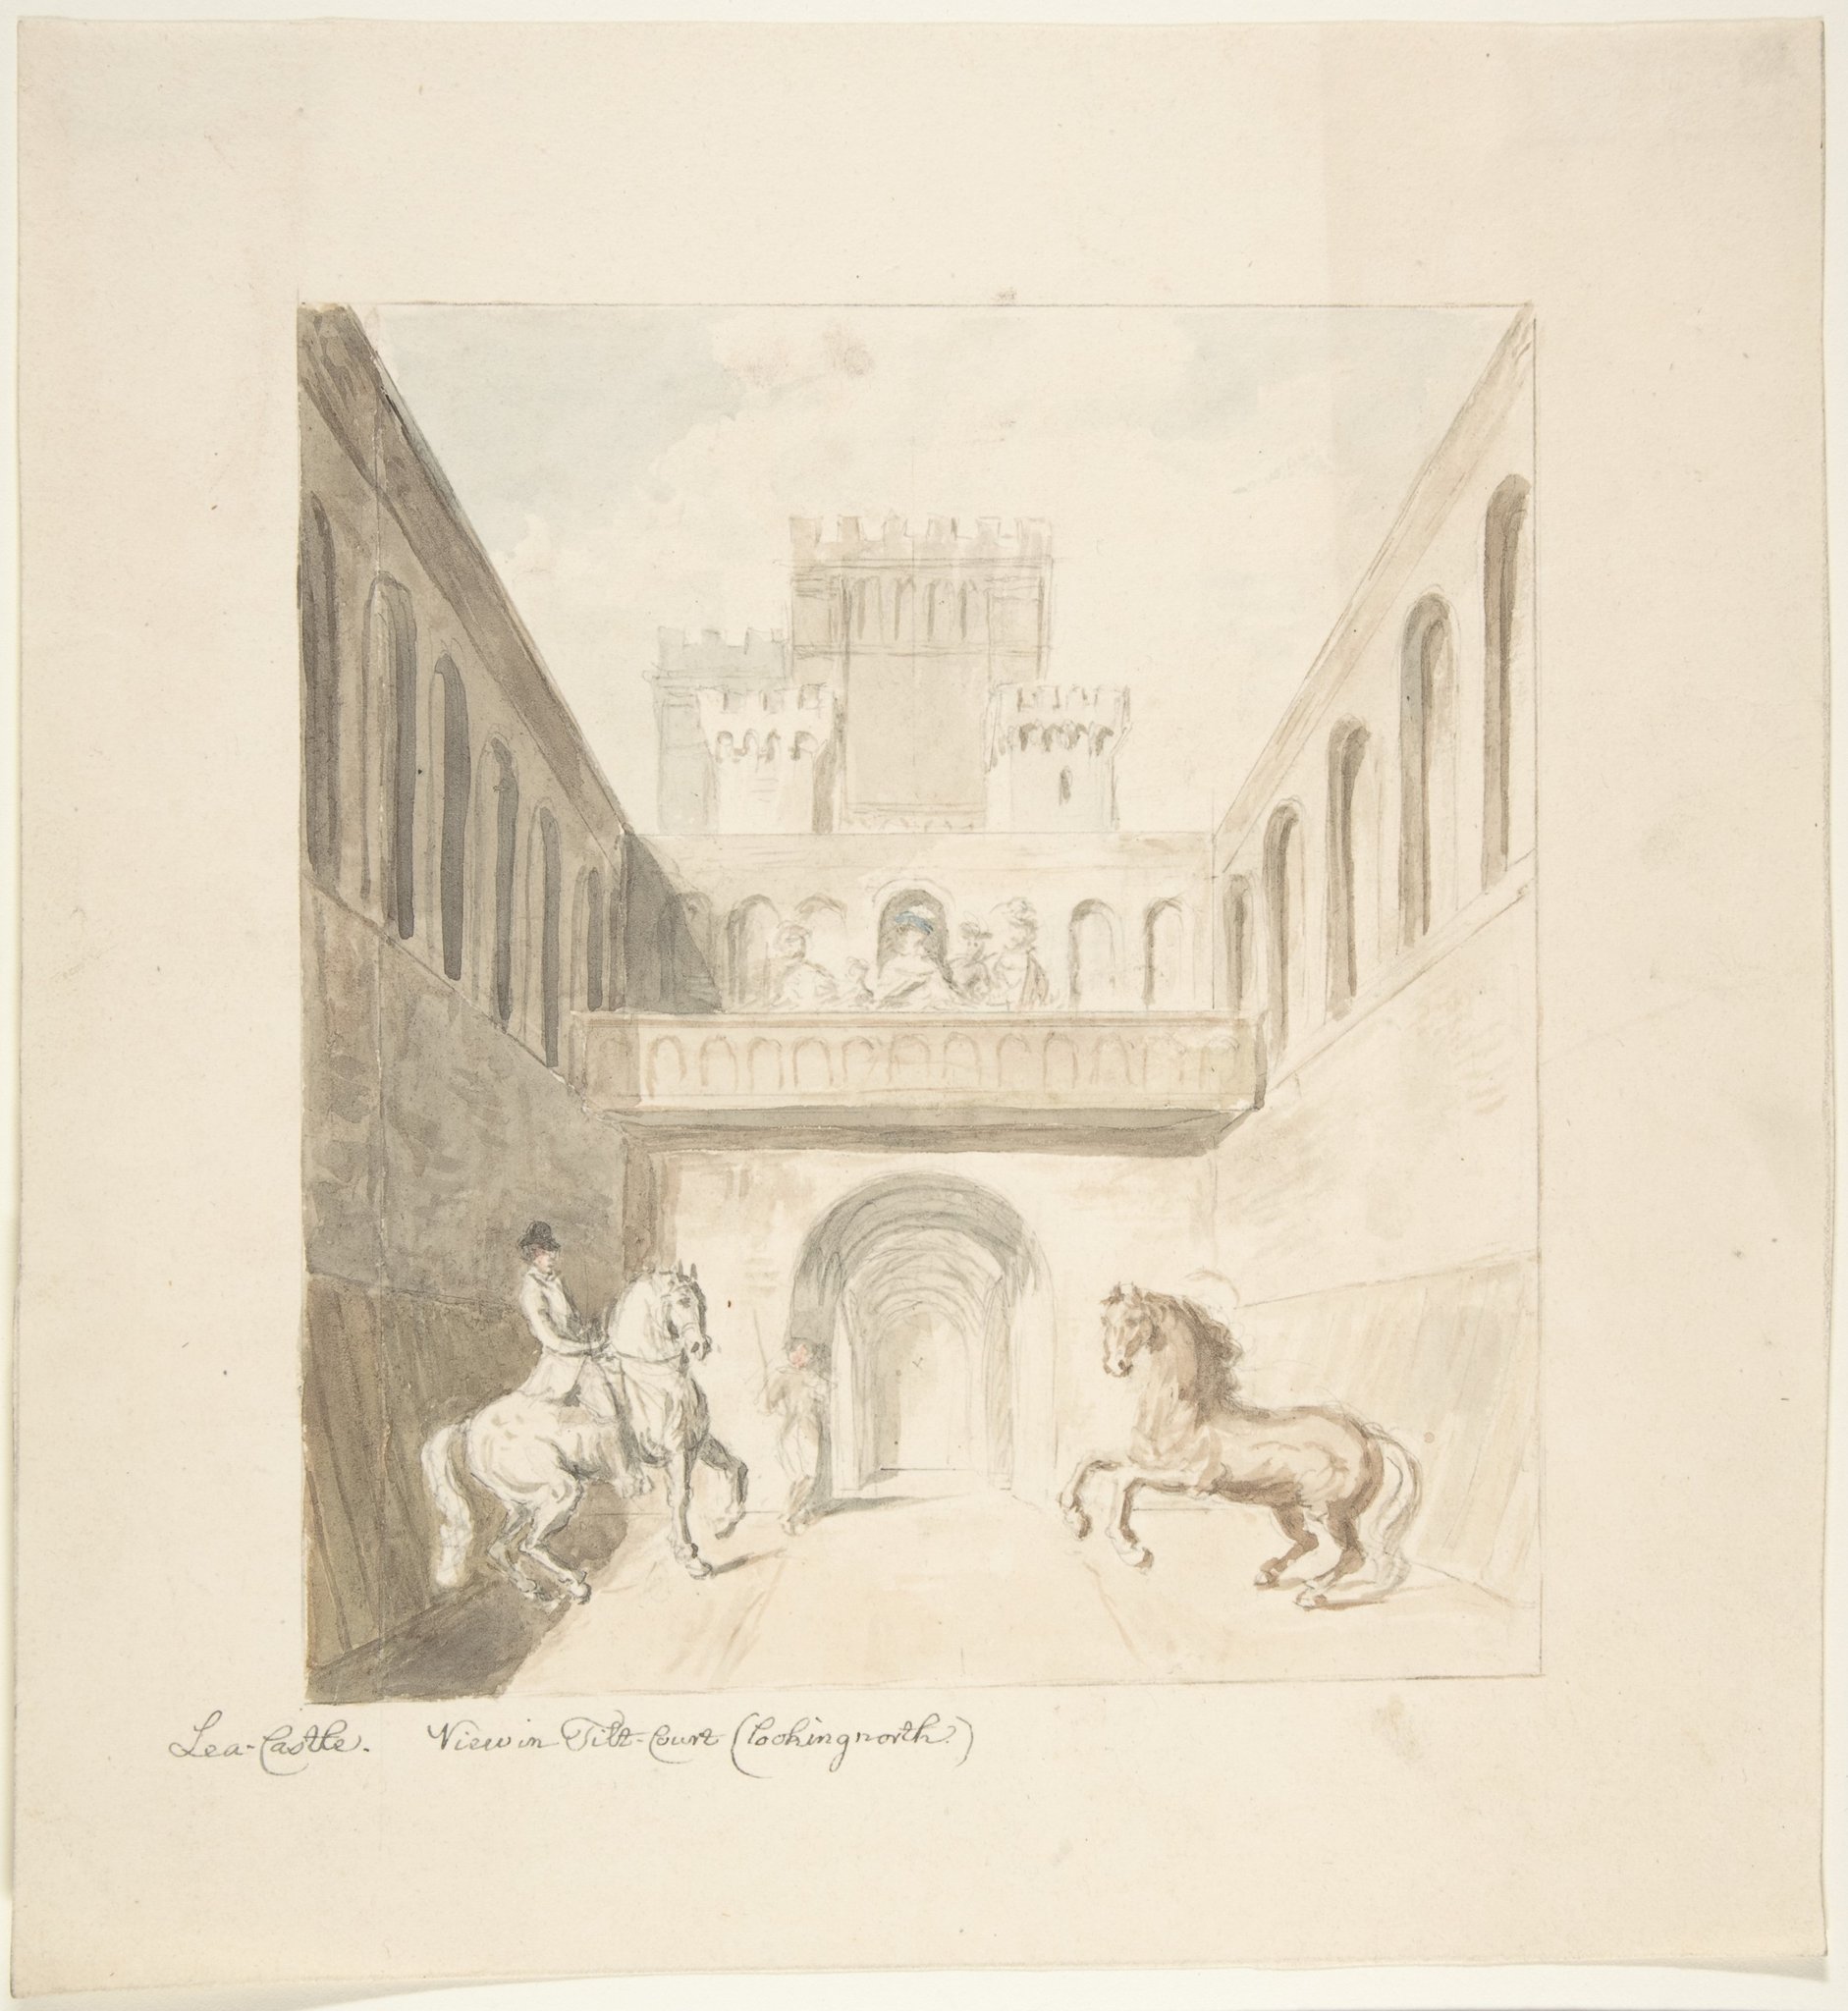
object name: drawing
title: Lea Castle, View in Tilt-Court, Facing North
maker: john carter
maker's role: artist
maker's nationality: british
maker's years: 1748-1817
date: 1816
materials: graphite, ink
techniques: brush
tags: castles,horses